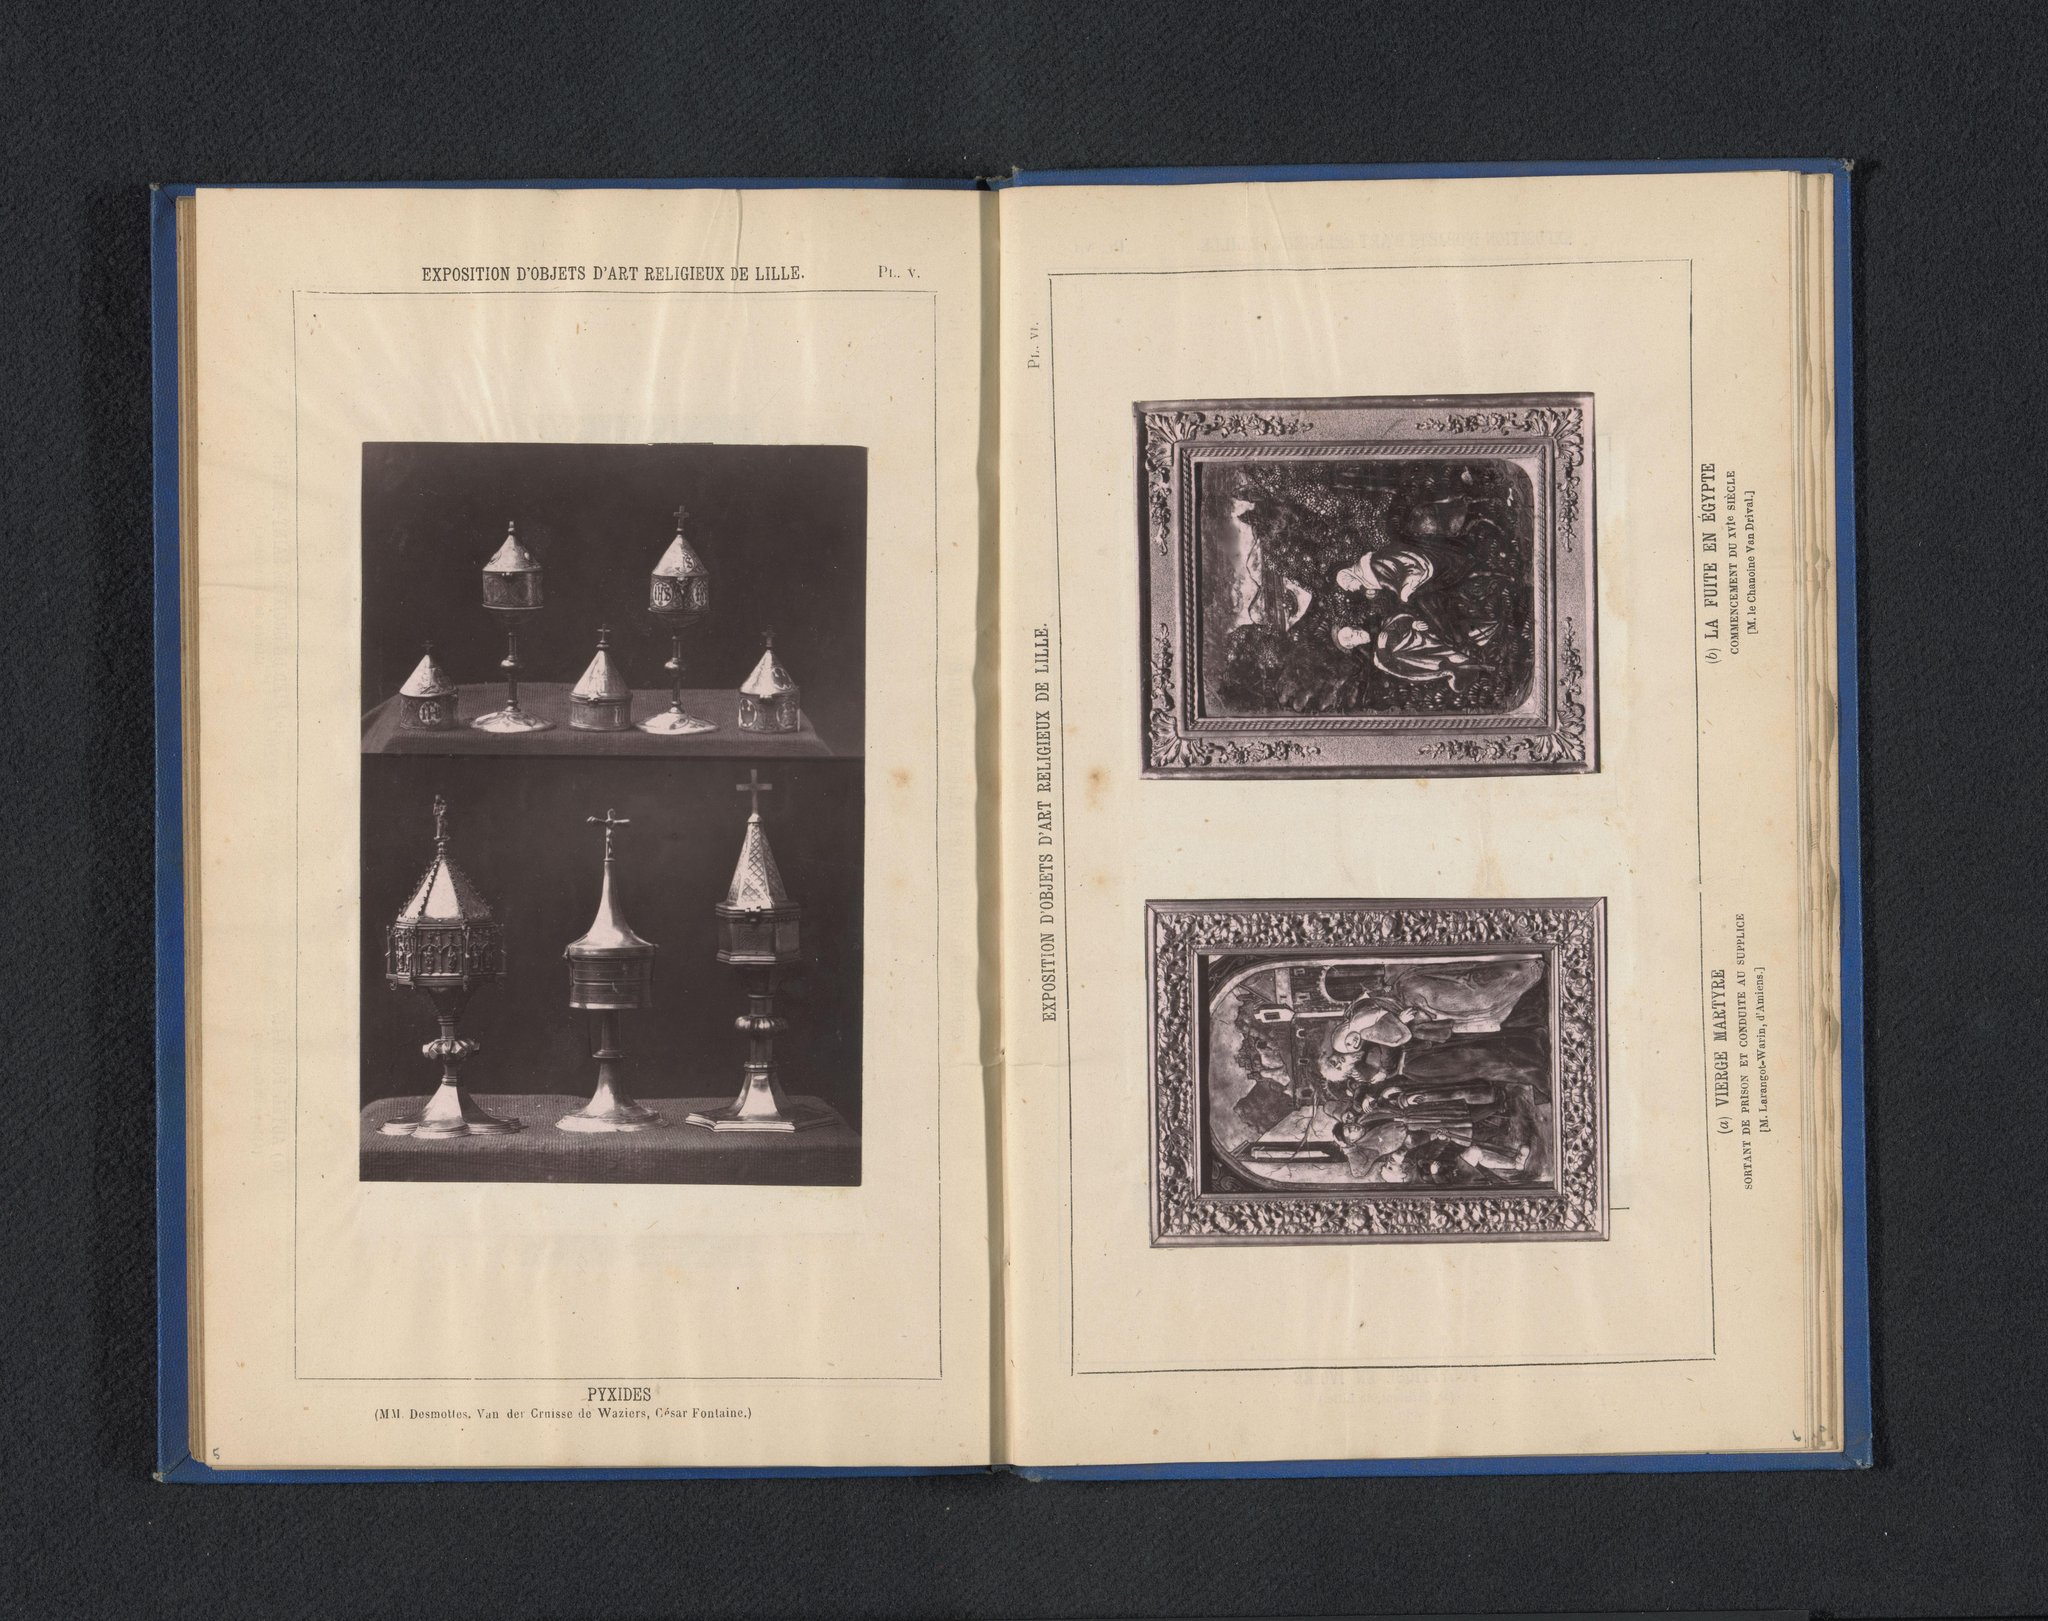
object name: page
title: Pyxides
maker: Anonymous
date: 1871-1876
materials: cardboard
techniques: woodburytype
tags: pyx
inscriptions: inscription: ‘Exposition d'objets d'art religieux de Lille’, inscription: ‘MM. Desmottes, Van der Cruisse Waziers, César Fontaine’, inscription: ‘Pl. V.’